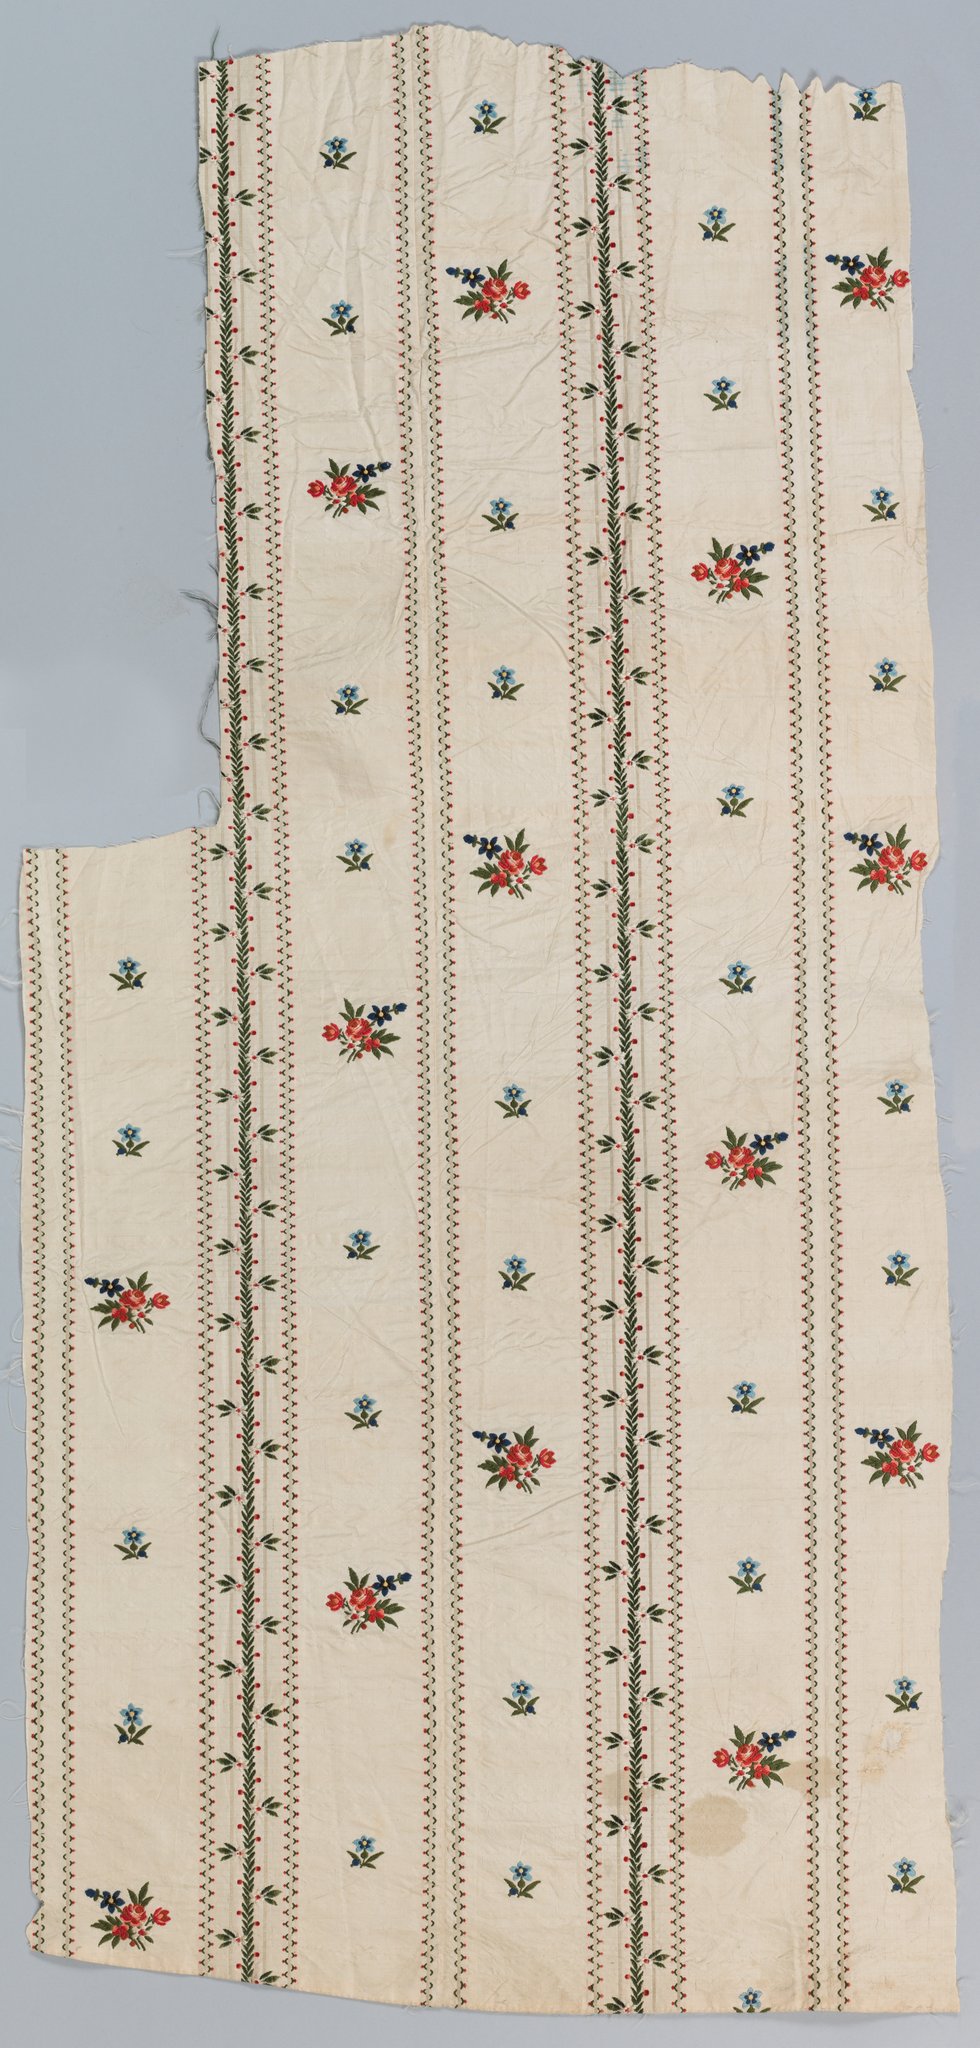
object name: piece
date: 1780-1790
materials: silk